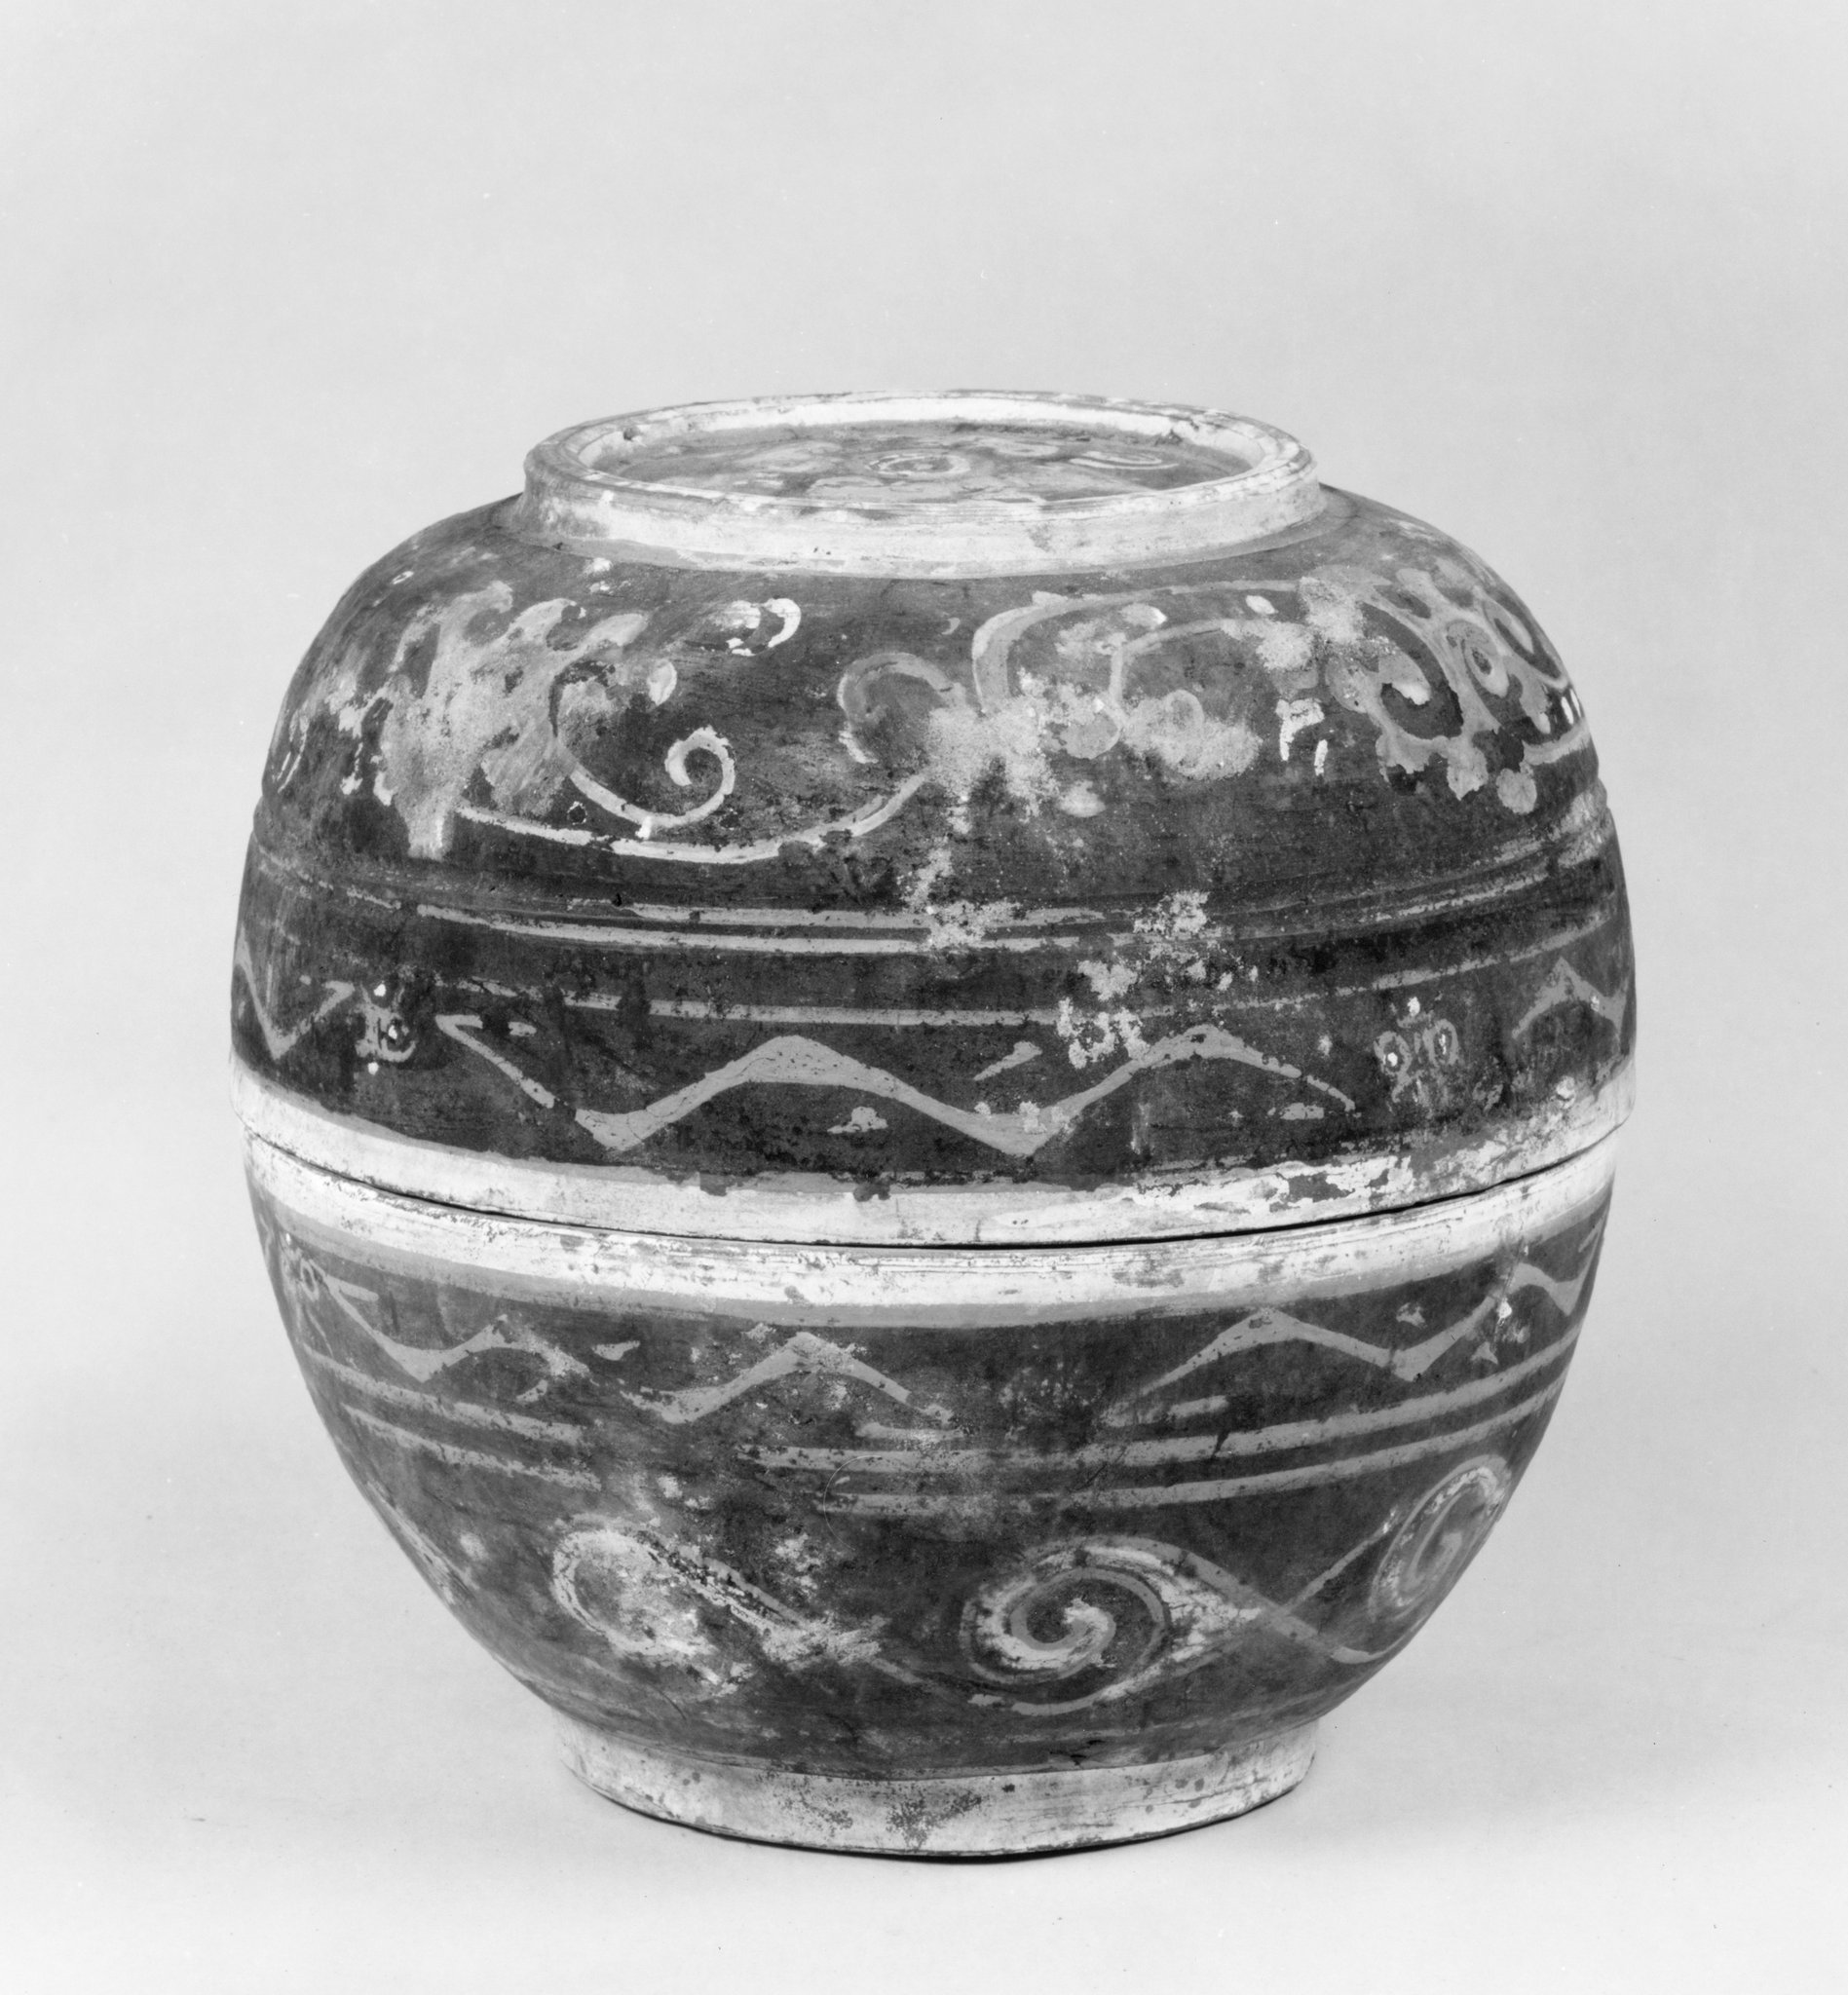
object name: bowl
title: Covered Bowl (He)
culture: chinese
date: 206 BCE-220 CE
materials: earthenware, pigment